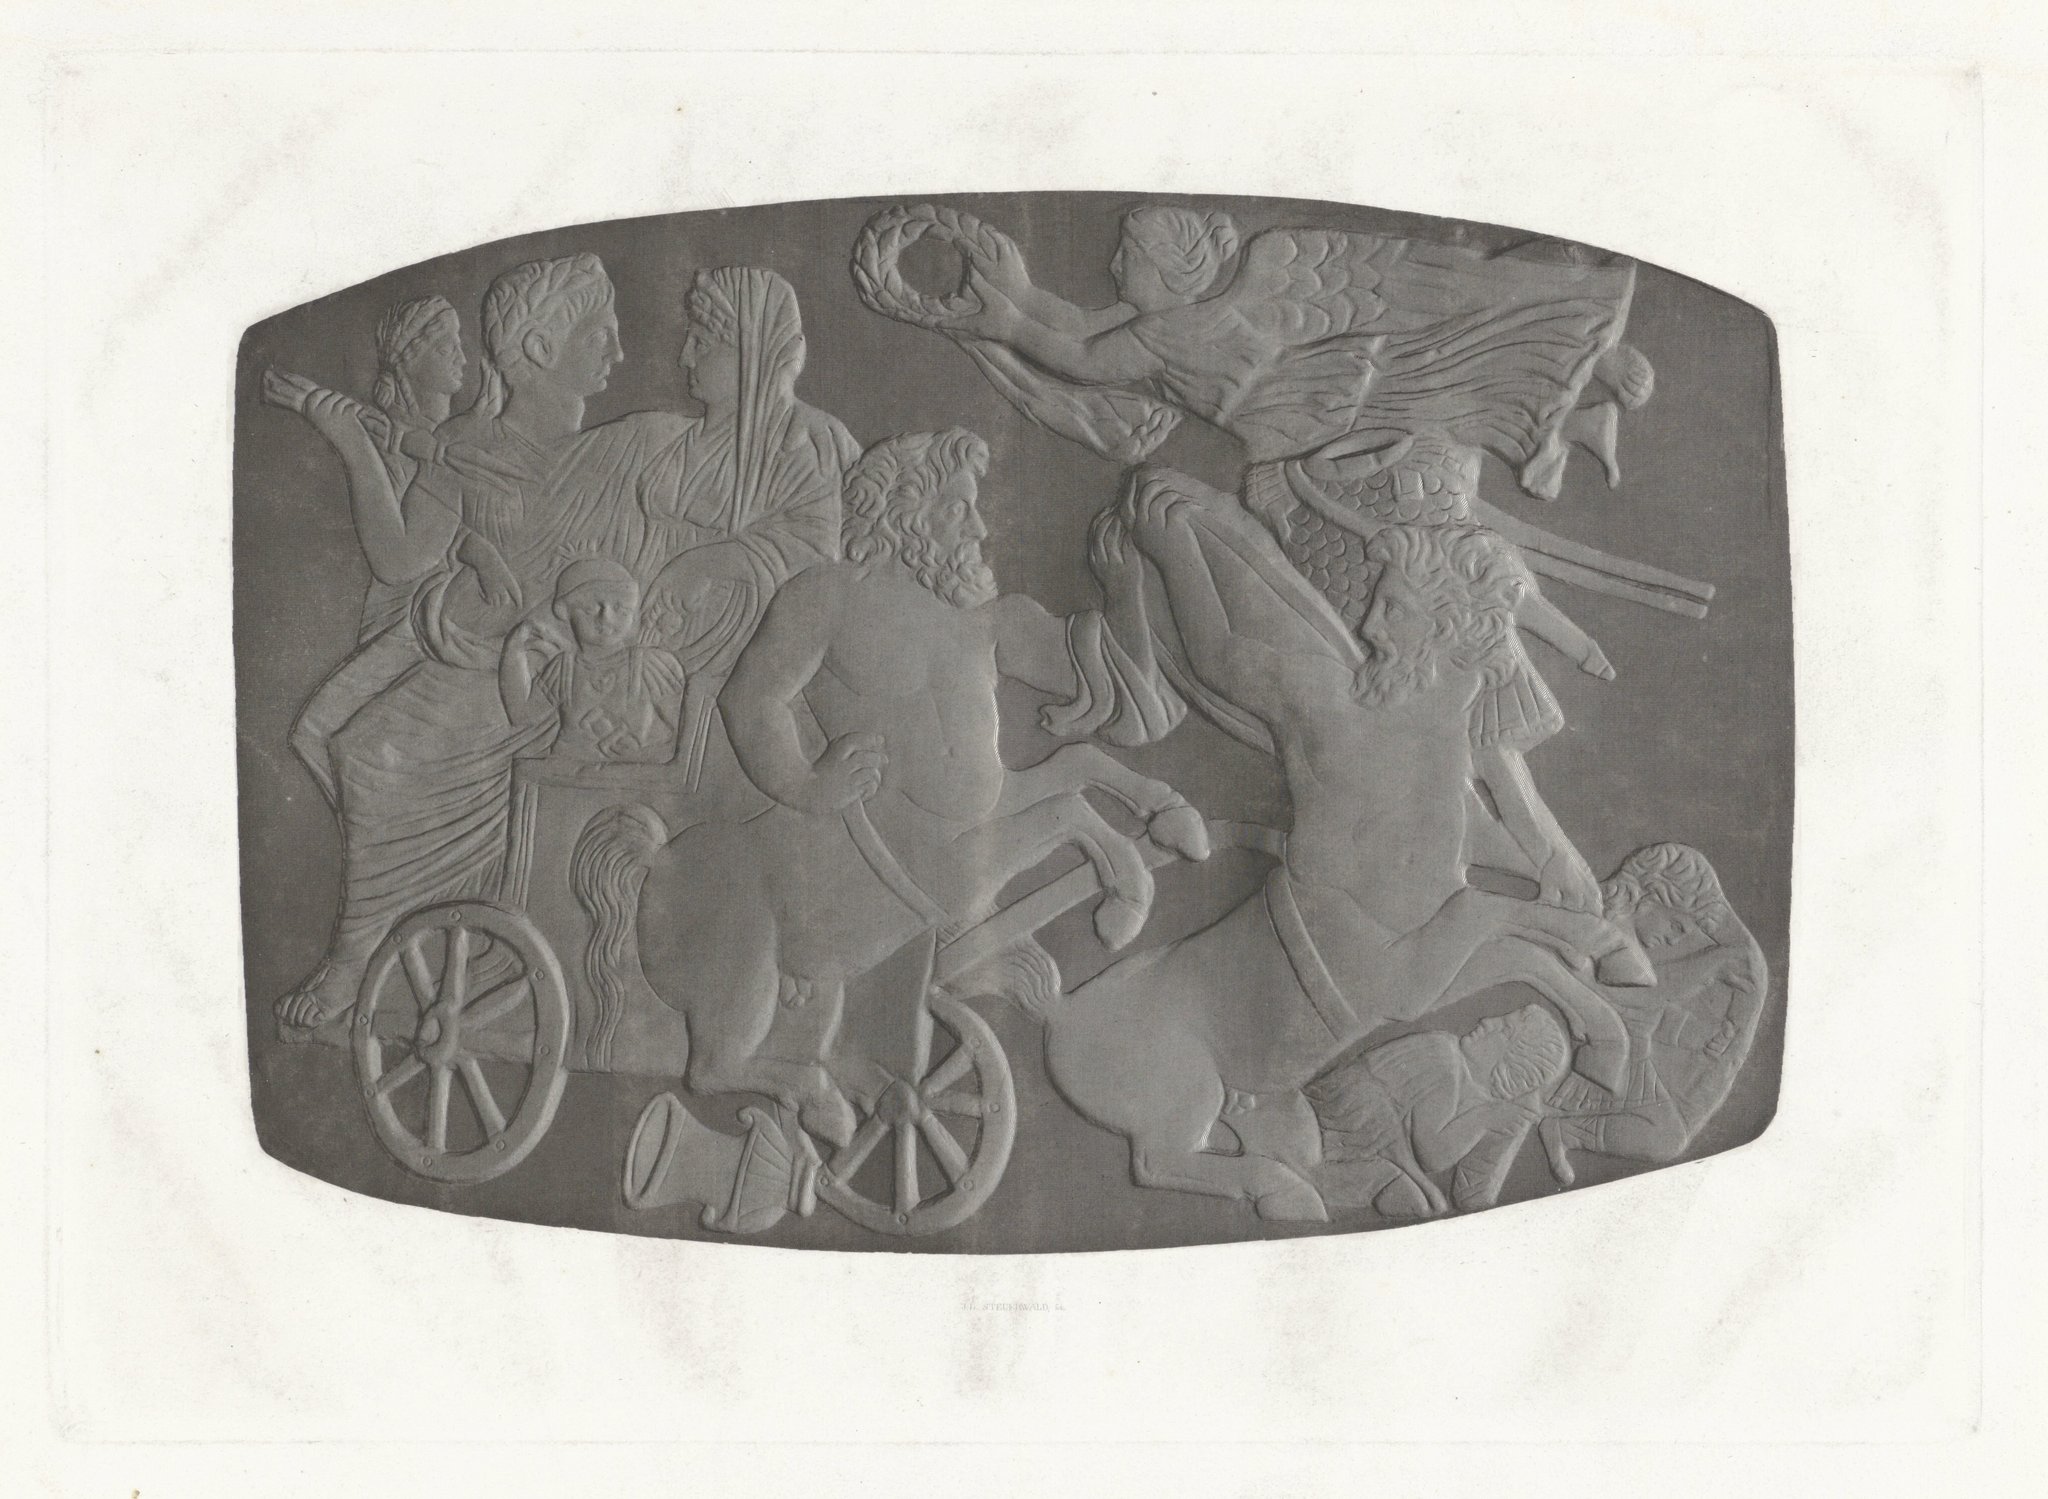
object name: print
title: Camee met de triomf van Germanicus en Agrippina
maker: jan dam steuerwald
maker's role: print maker, printer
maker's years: 1805-1869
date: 1839-1863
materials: paper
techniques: relief engraving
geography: netherlands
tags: conqueror triumphing, triumphal entry of victor, piece of sculpture, reproduction of a piece of sculpture, fame; 'fama', 'fama buona', 'fama chiara' (ripa)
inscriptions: collector's mark: Lugt 2228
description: Een camee met een voorstelling van de triomf van Germanicus en Agrippina (of de triomf van Constantijn). Een Romeinse veldheer met zijn echtgenote in een triomfwagen getrokken door twee centauren. Hij wordt door Faam gekroond.